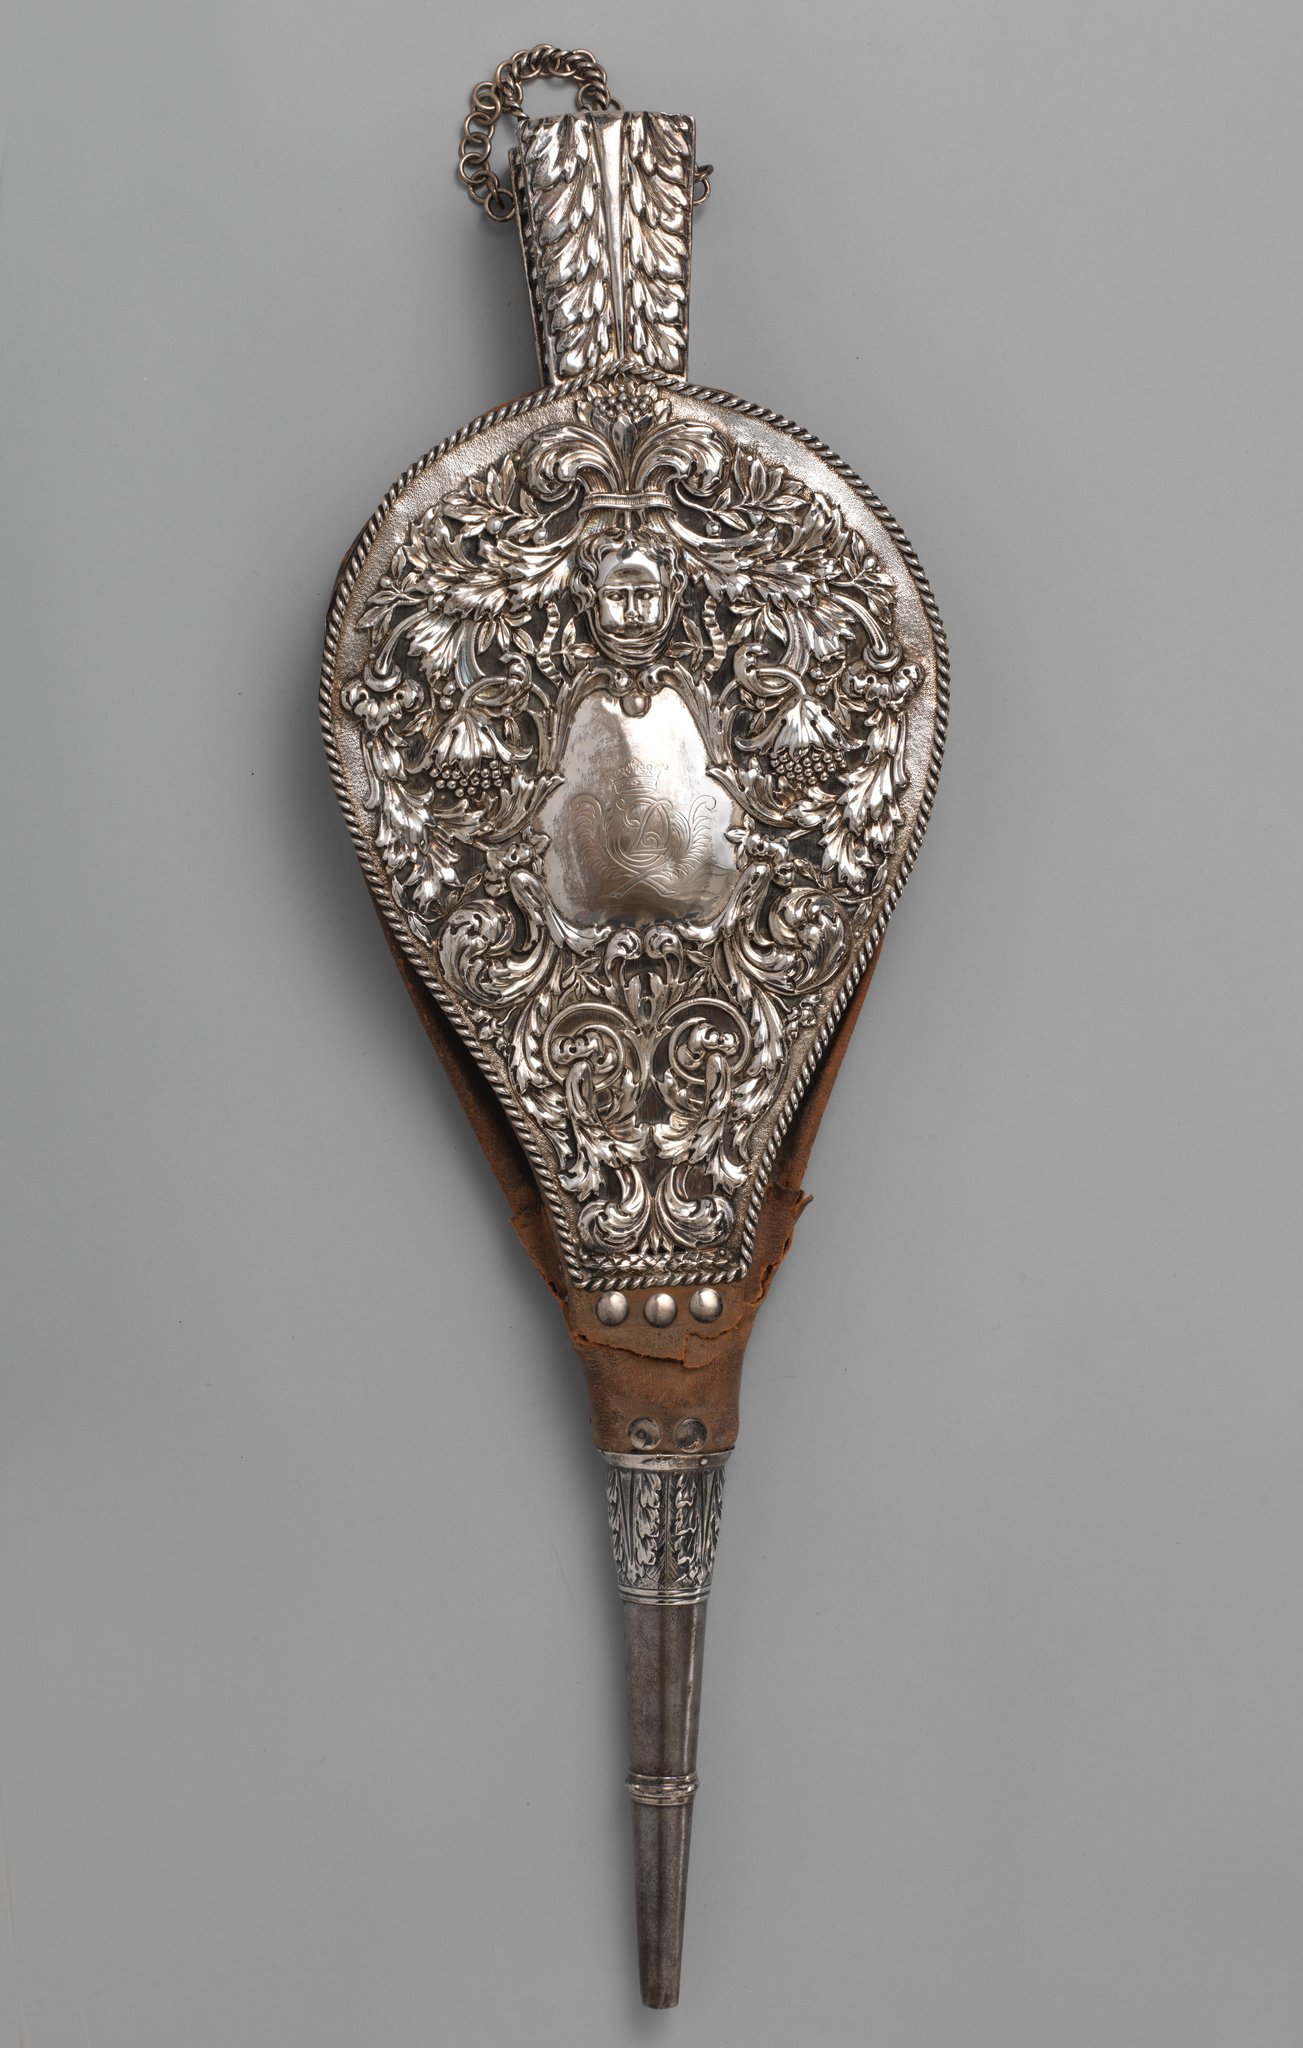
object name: bellow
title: Bellows (part of a set)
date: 1675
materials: iron, leather, silver, wood